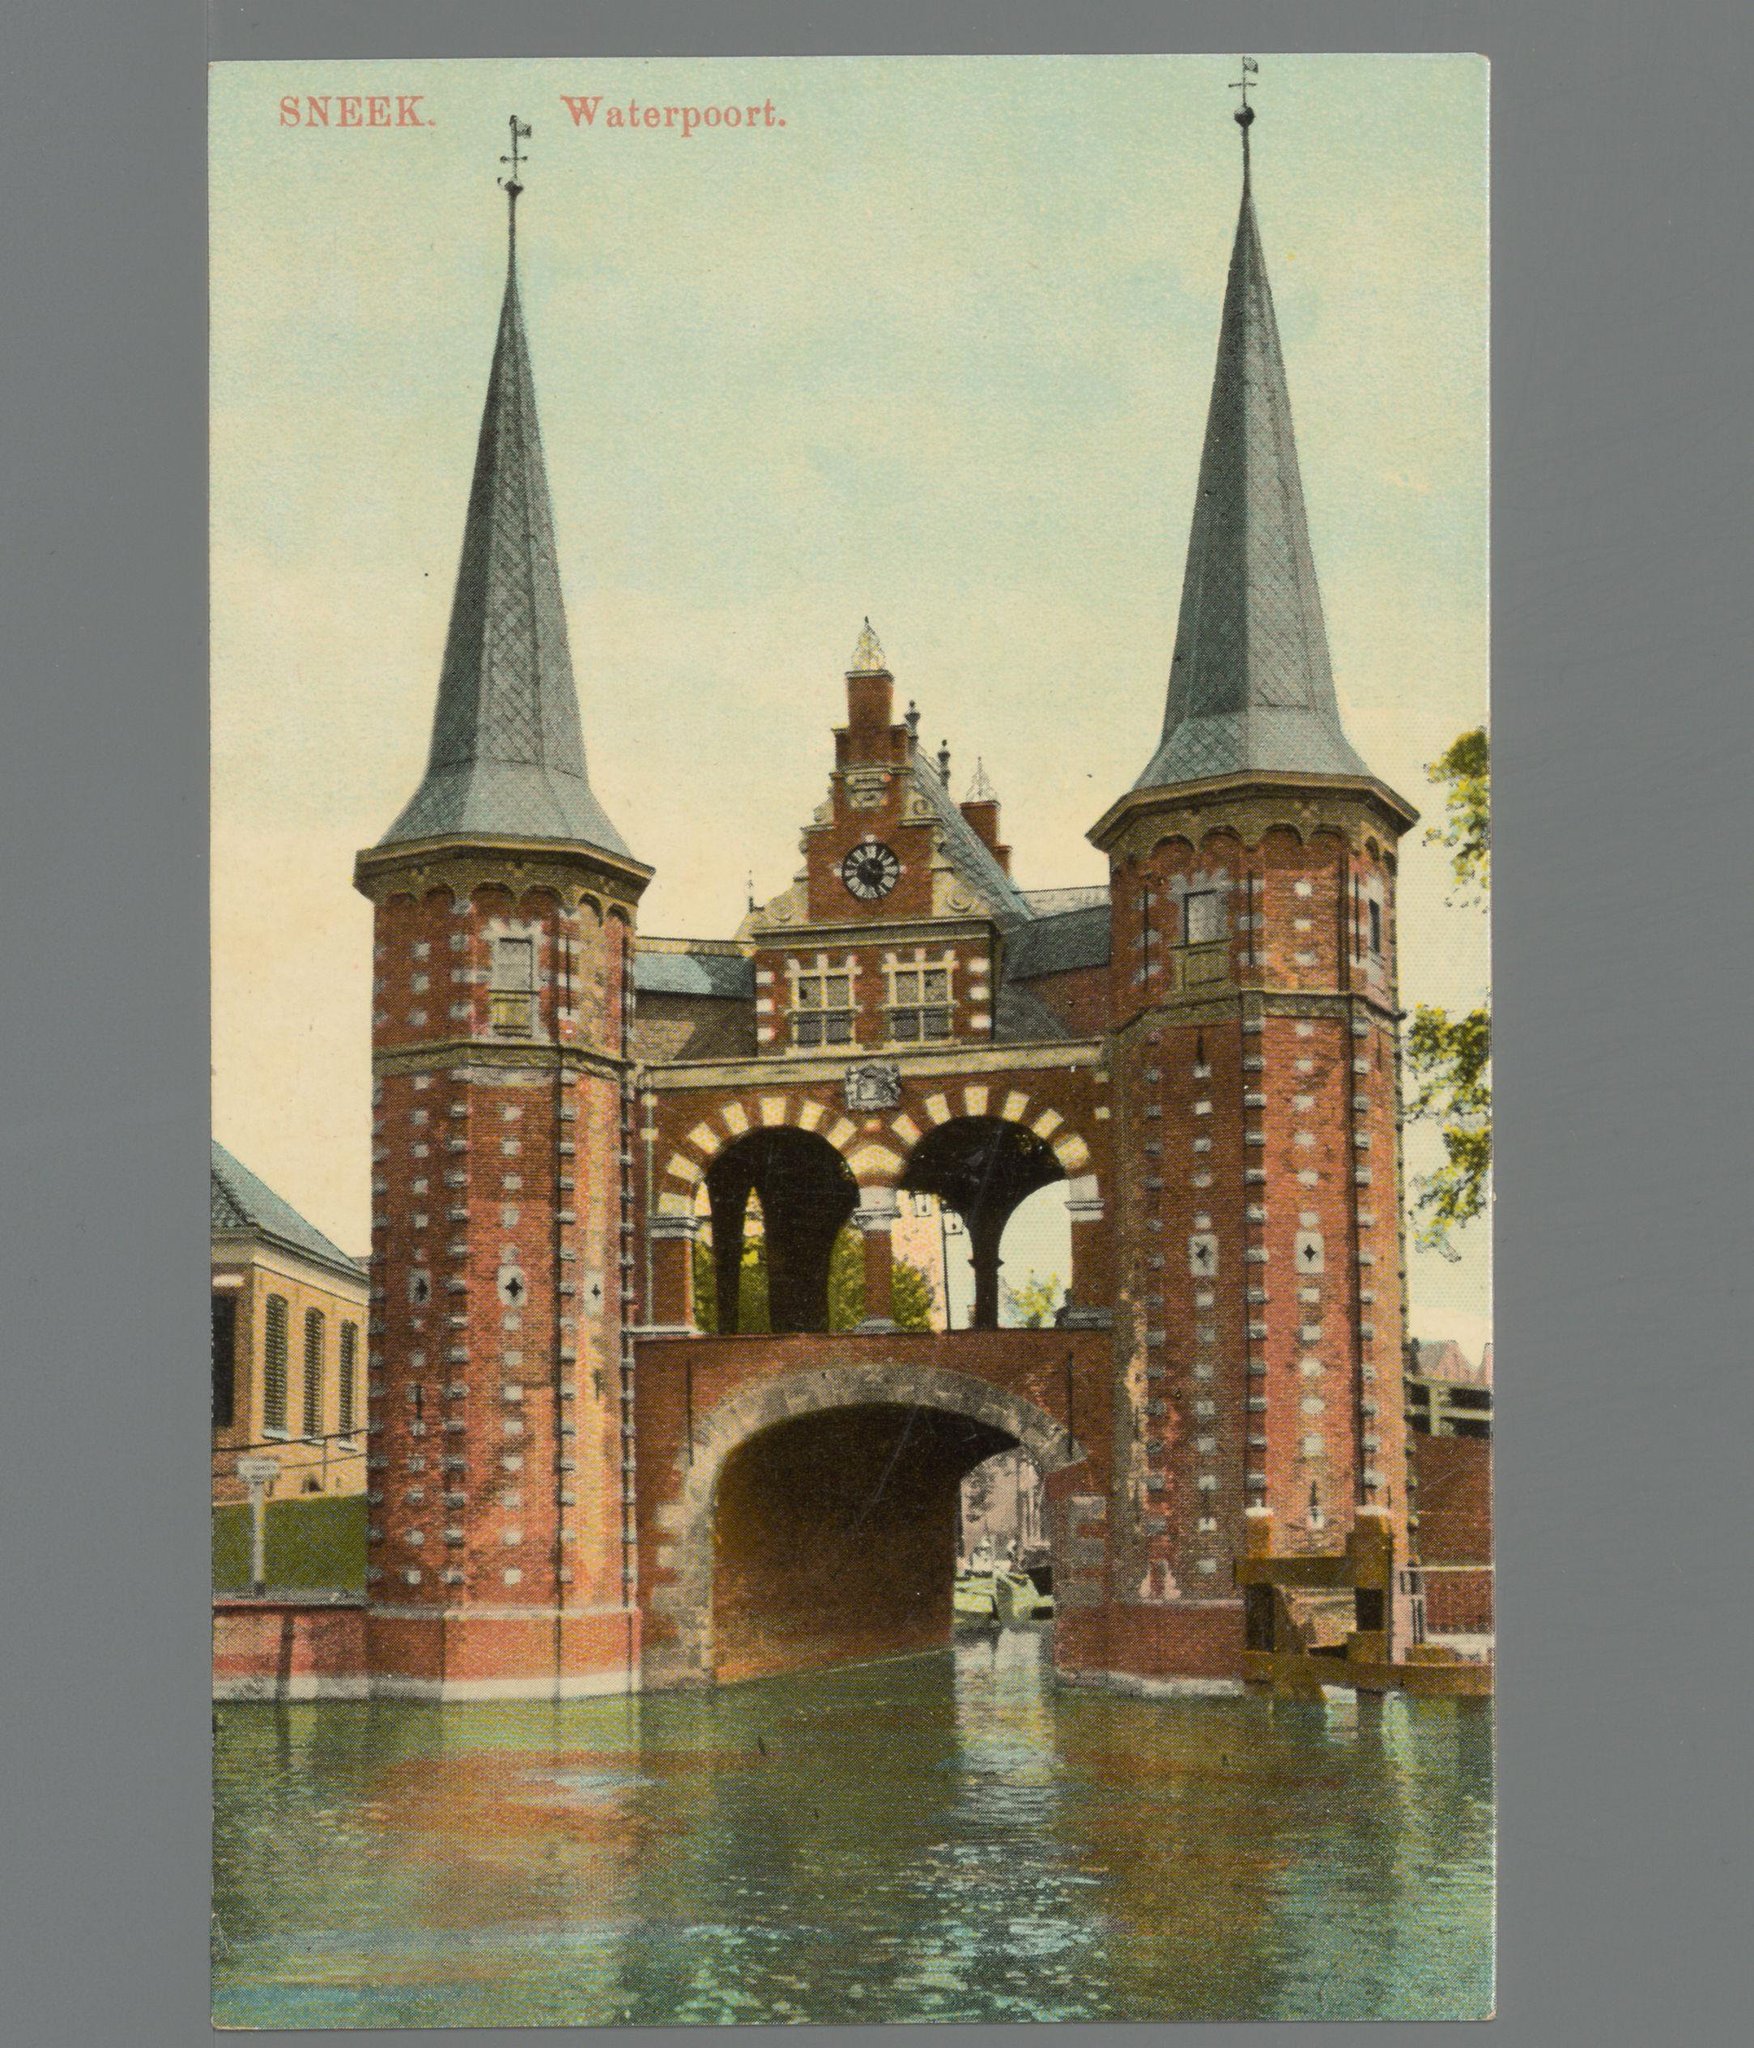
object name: photomechanical print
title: Sneek. Waterpoort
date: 1905-1930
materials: cardboard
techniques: lithograph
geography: arnhem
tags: watergate